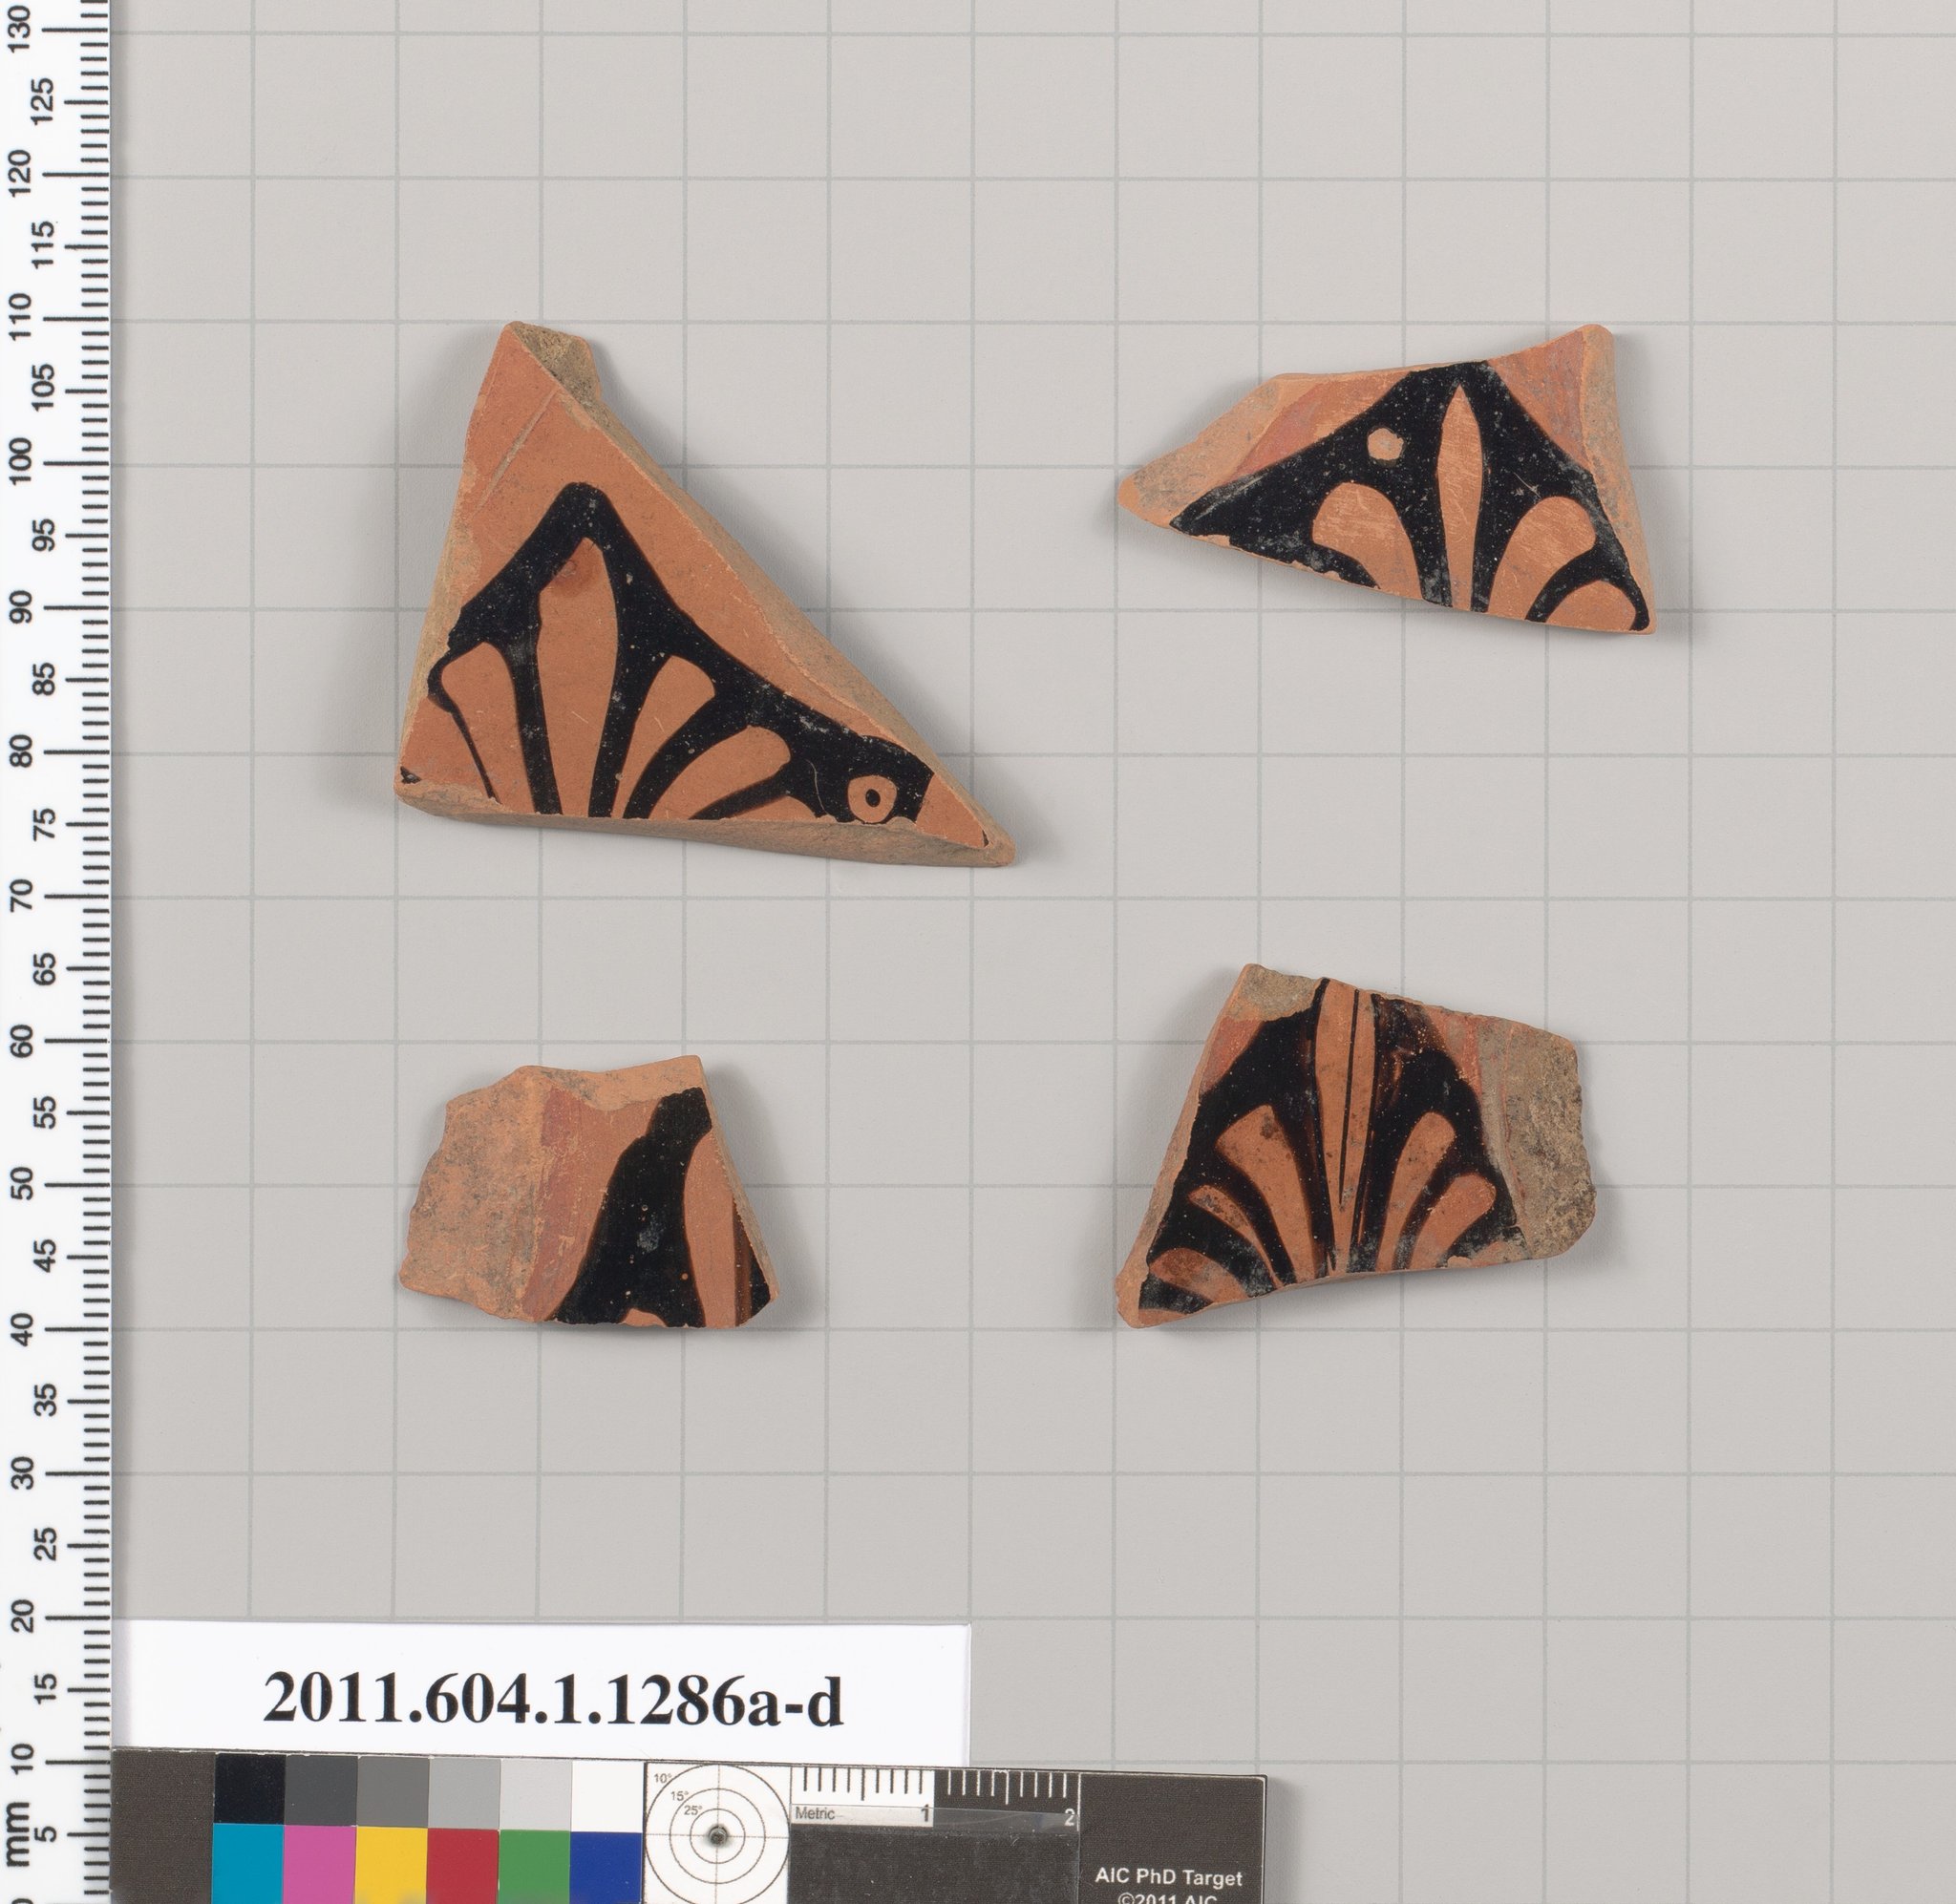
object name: kylix fragment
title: Terracotta fragments of kylikes (drinking cups)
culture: greek, attic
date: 500-401 BCE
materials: terracotta